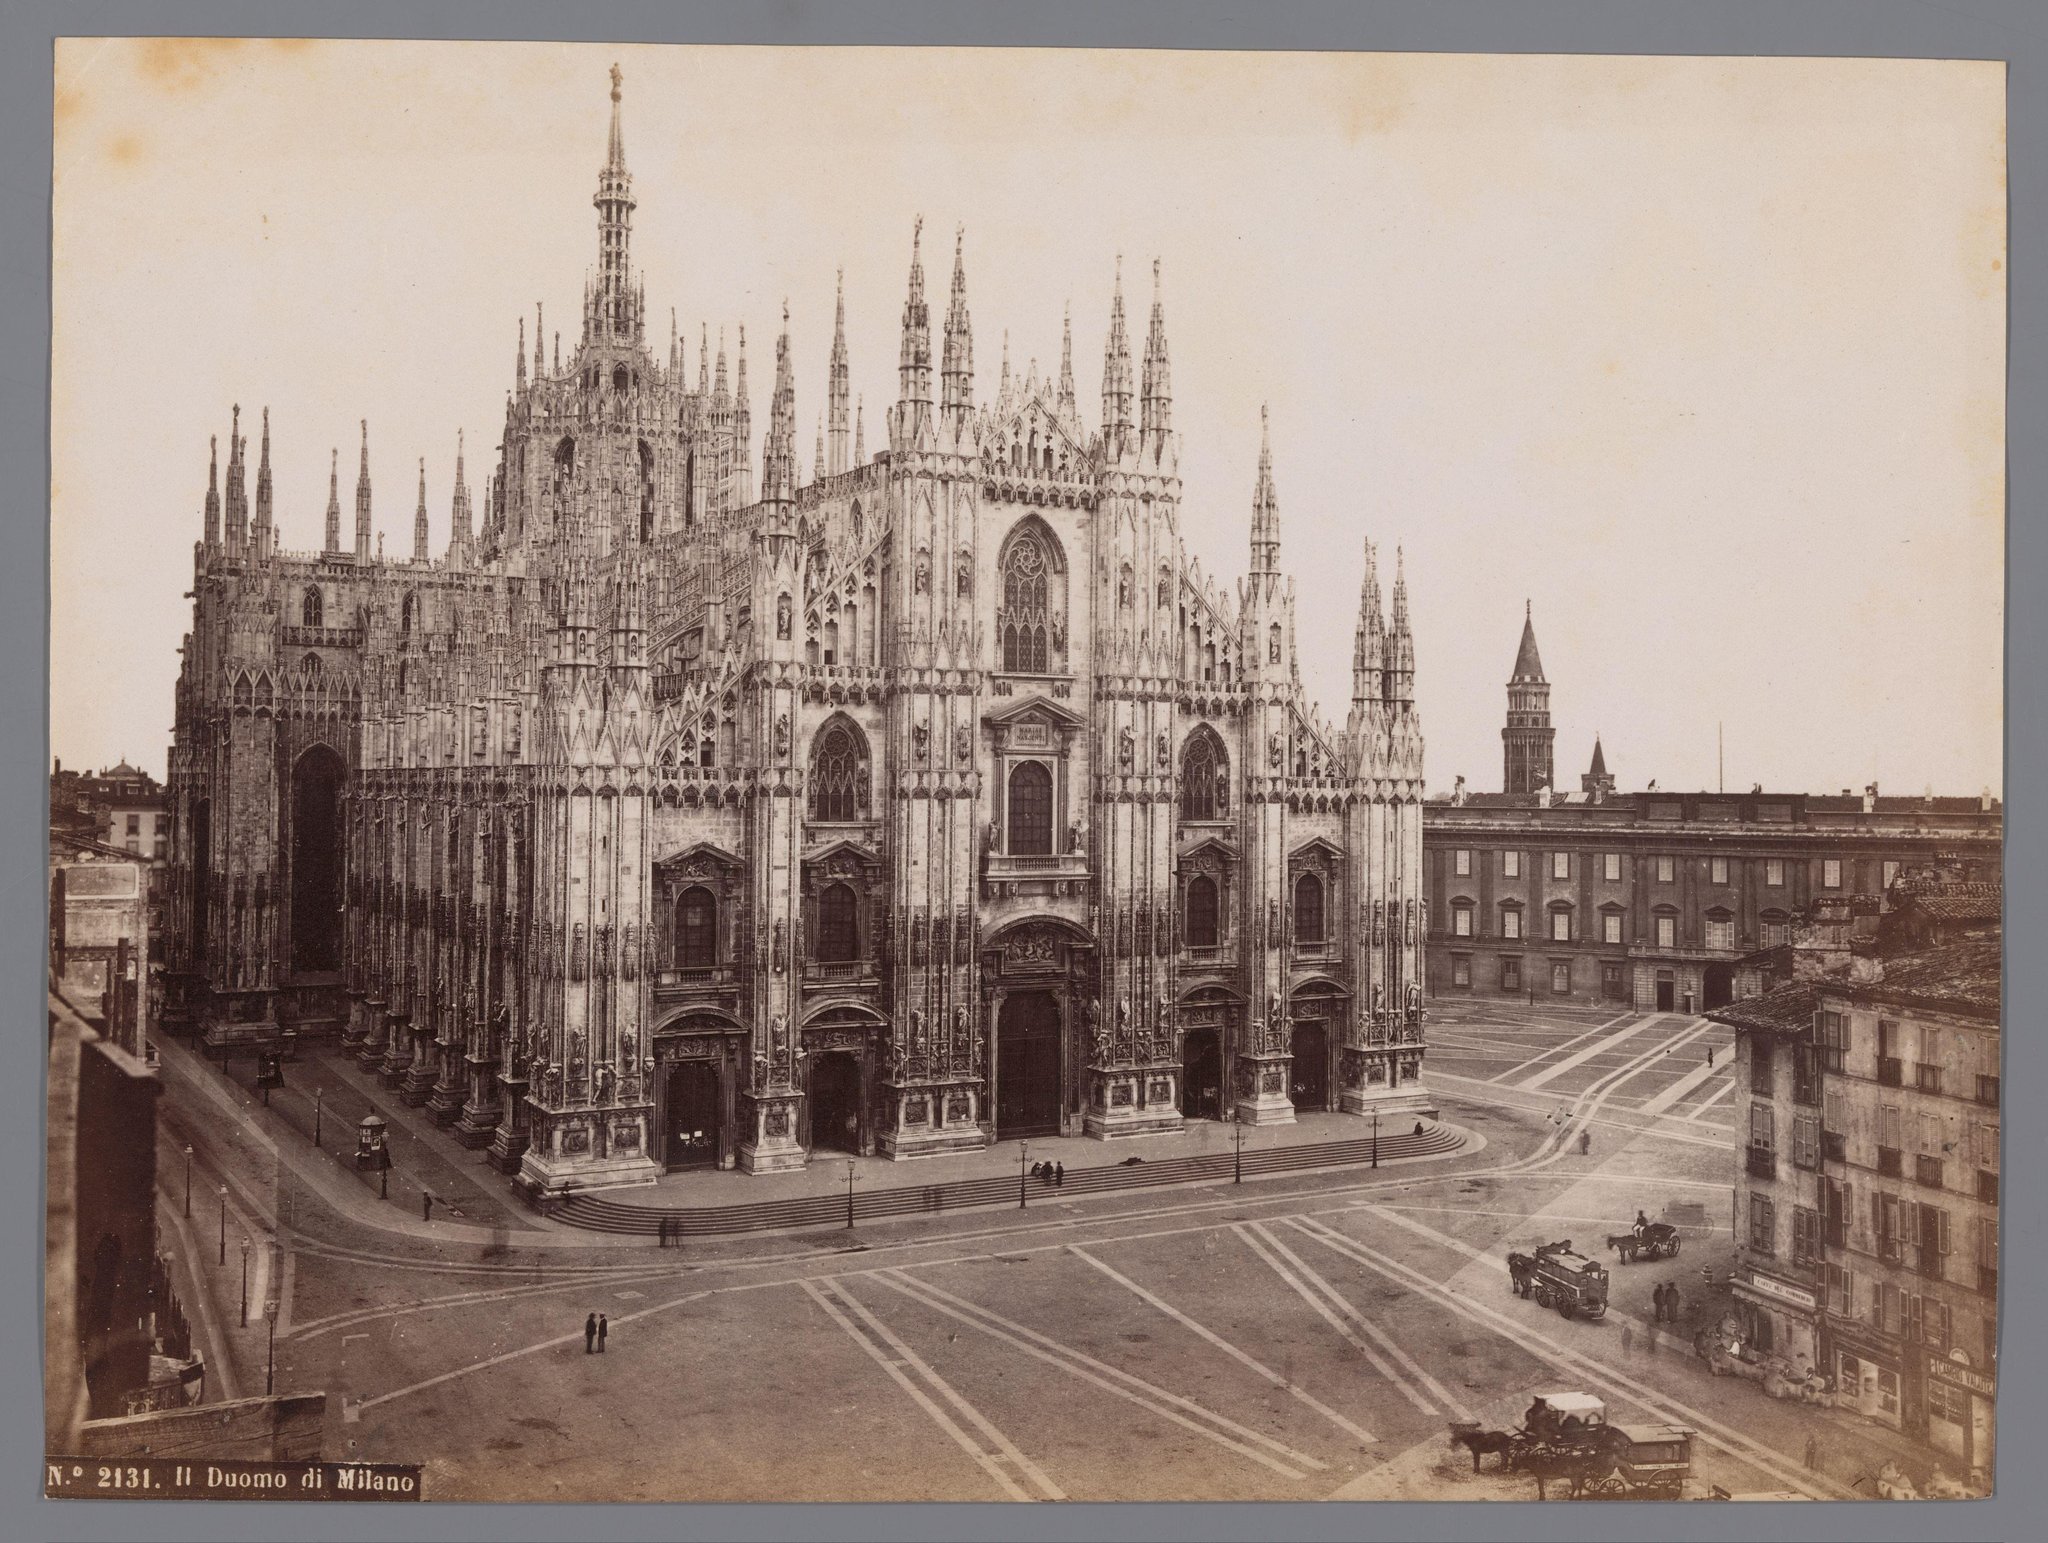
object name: photograph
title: Gezicht op de noordwestzijde van de kathedraal van Milaan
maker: Anonymous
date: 1851-1900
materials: paper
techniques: albumen print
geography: milan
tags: parts of church exterior and annexes: west façade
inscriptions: number: ‘No. 2131.’